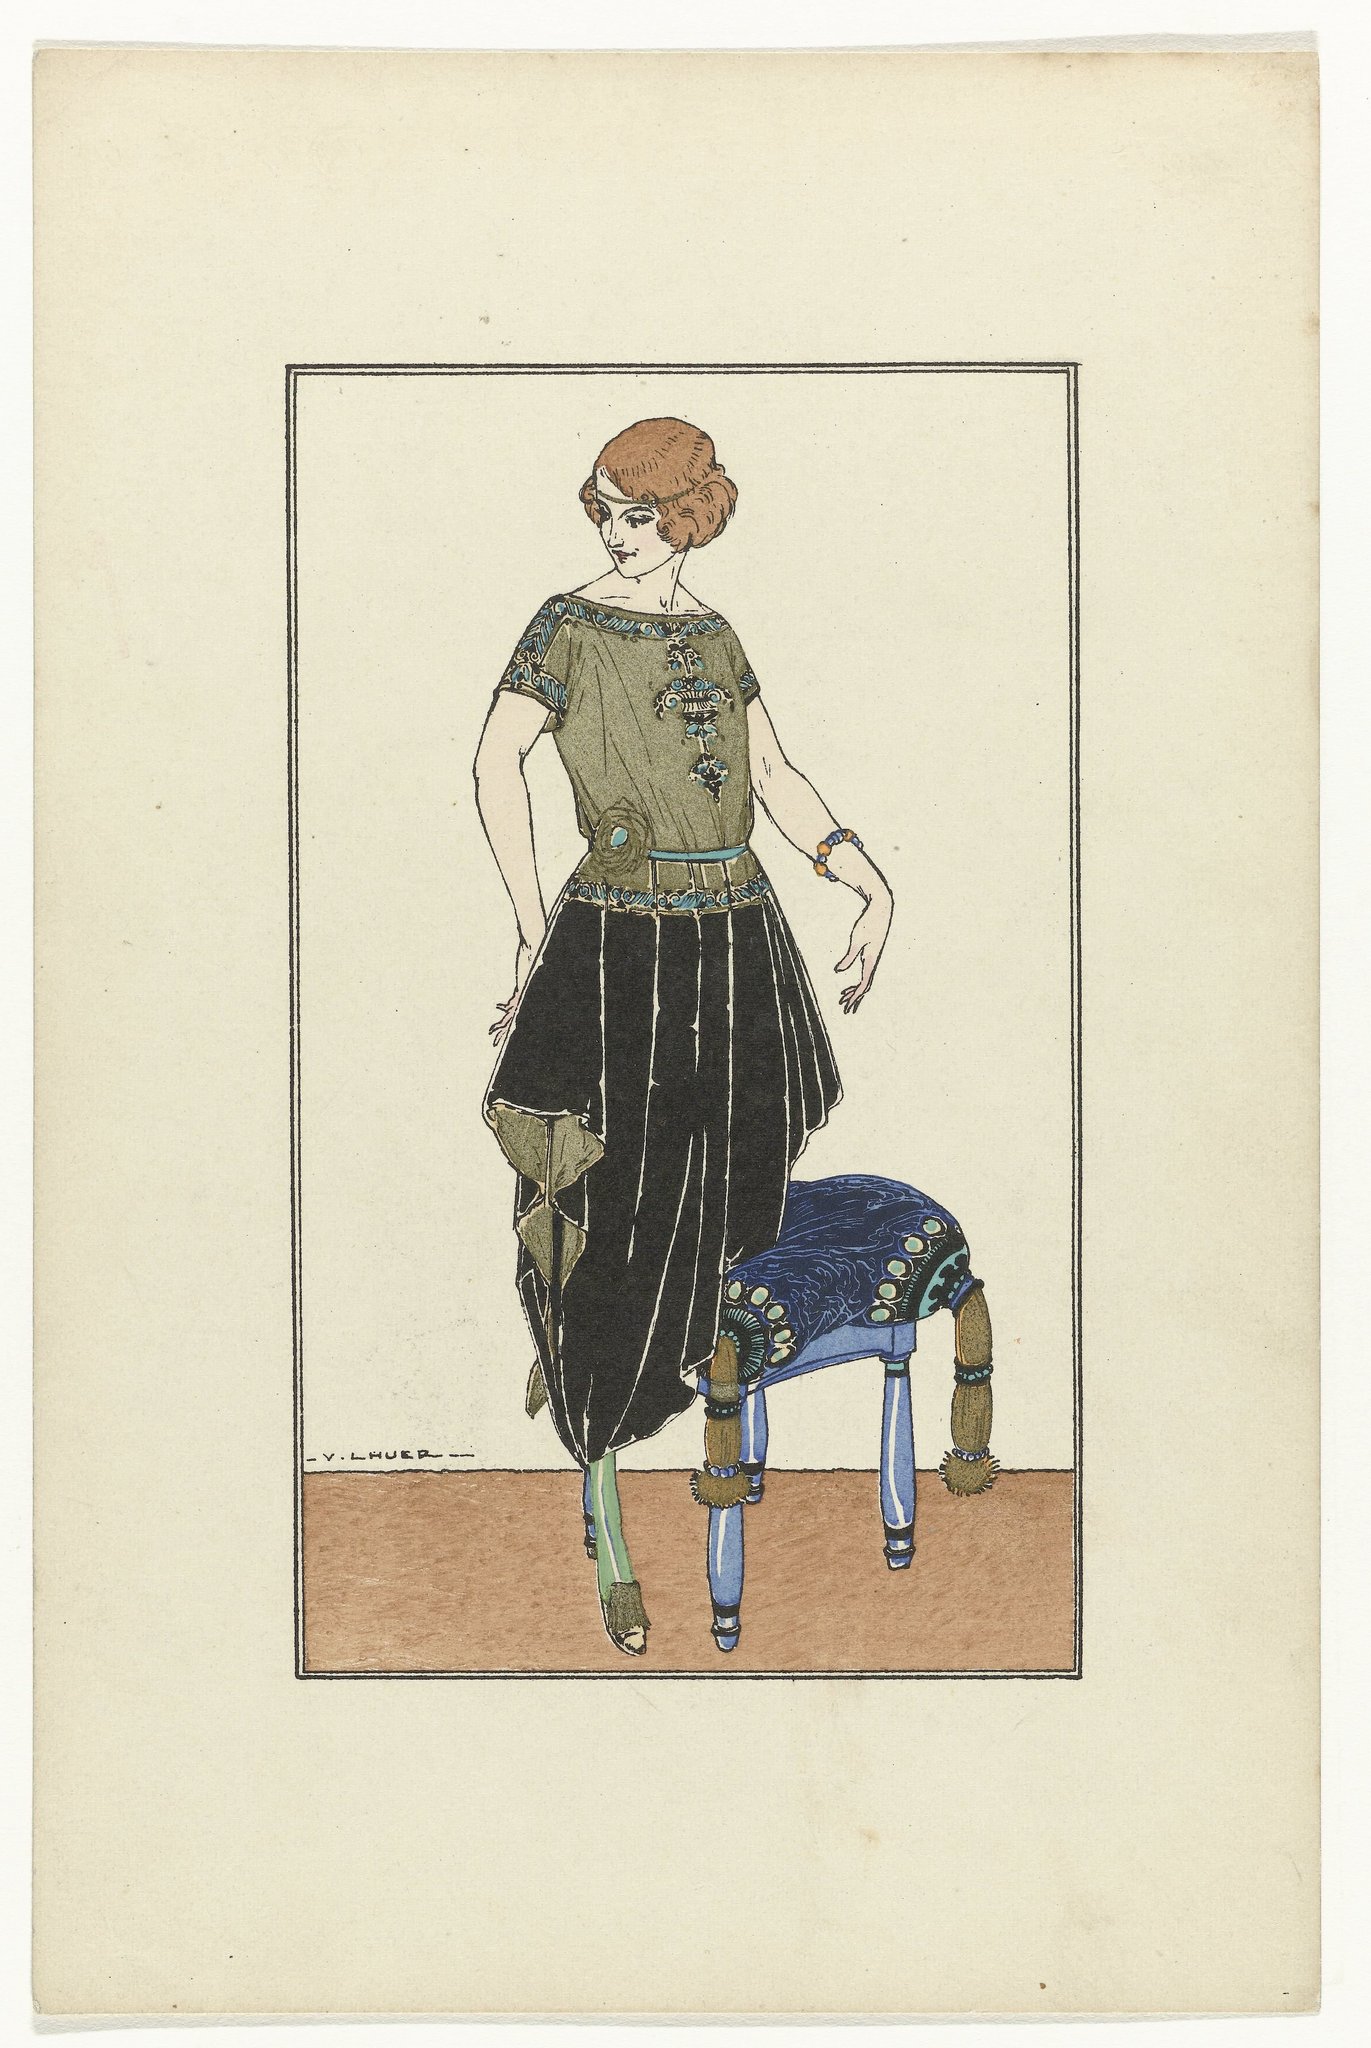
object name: fashion print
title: Ses modèles exclusifs, René Sacerdote, ca. 1921, No. 141 : Robe d'après-mid (...)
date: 1921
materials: paper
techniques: engraving, hand coloring, letterpress printing, pochoir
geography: paris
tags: diadem, tiara (+ women's clothes), fashion plates, dress, gown (+ women's clothes), bracelet, wristlet (+ women's clothes)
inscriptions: address: ‘René Sacerdote / 10, rue de Louvois - Paris (2e)’, inscription: ‘No. 141 / Robe d'après-midi / en velours noir, corsage en lamé or, brodé jais noir et bleu turquoise : fleurs velours noir.’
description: Middagjapon van zwart fluweel met een lijfje van goudlamé, geborduurd met zwarte en turquoise blauw git. Bloemen van zwart fluweel.